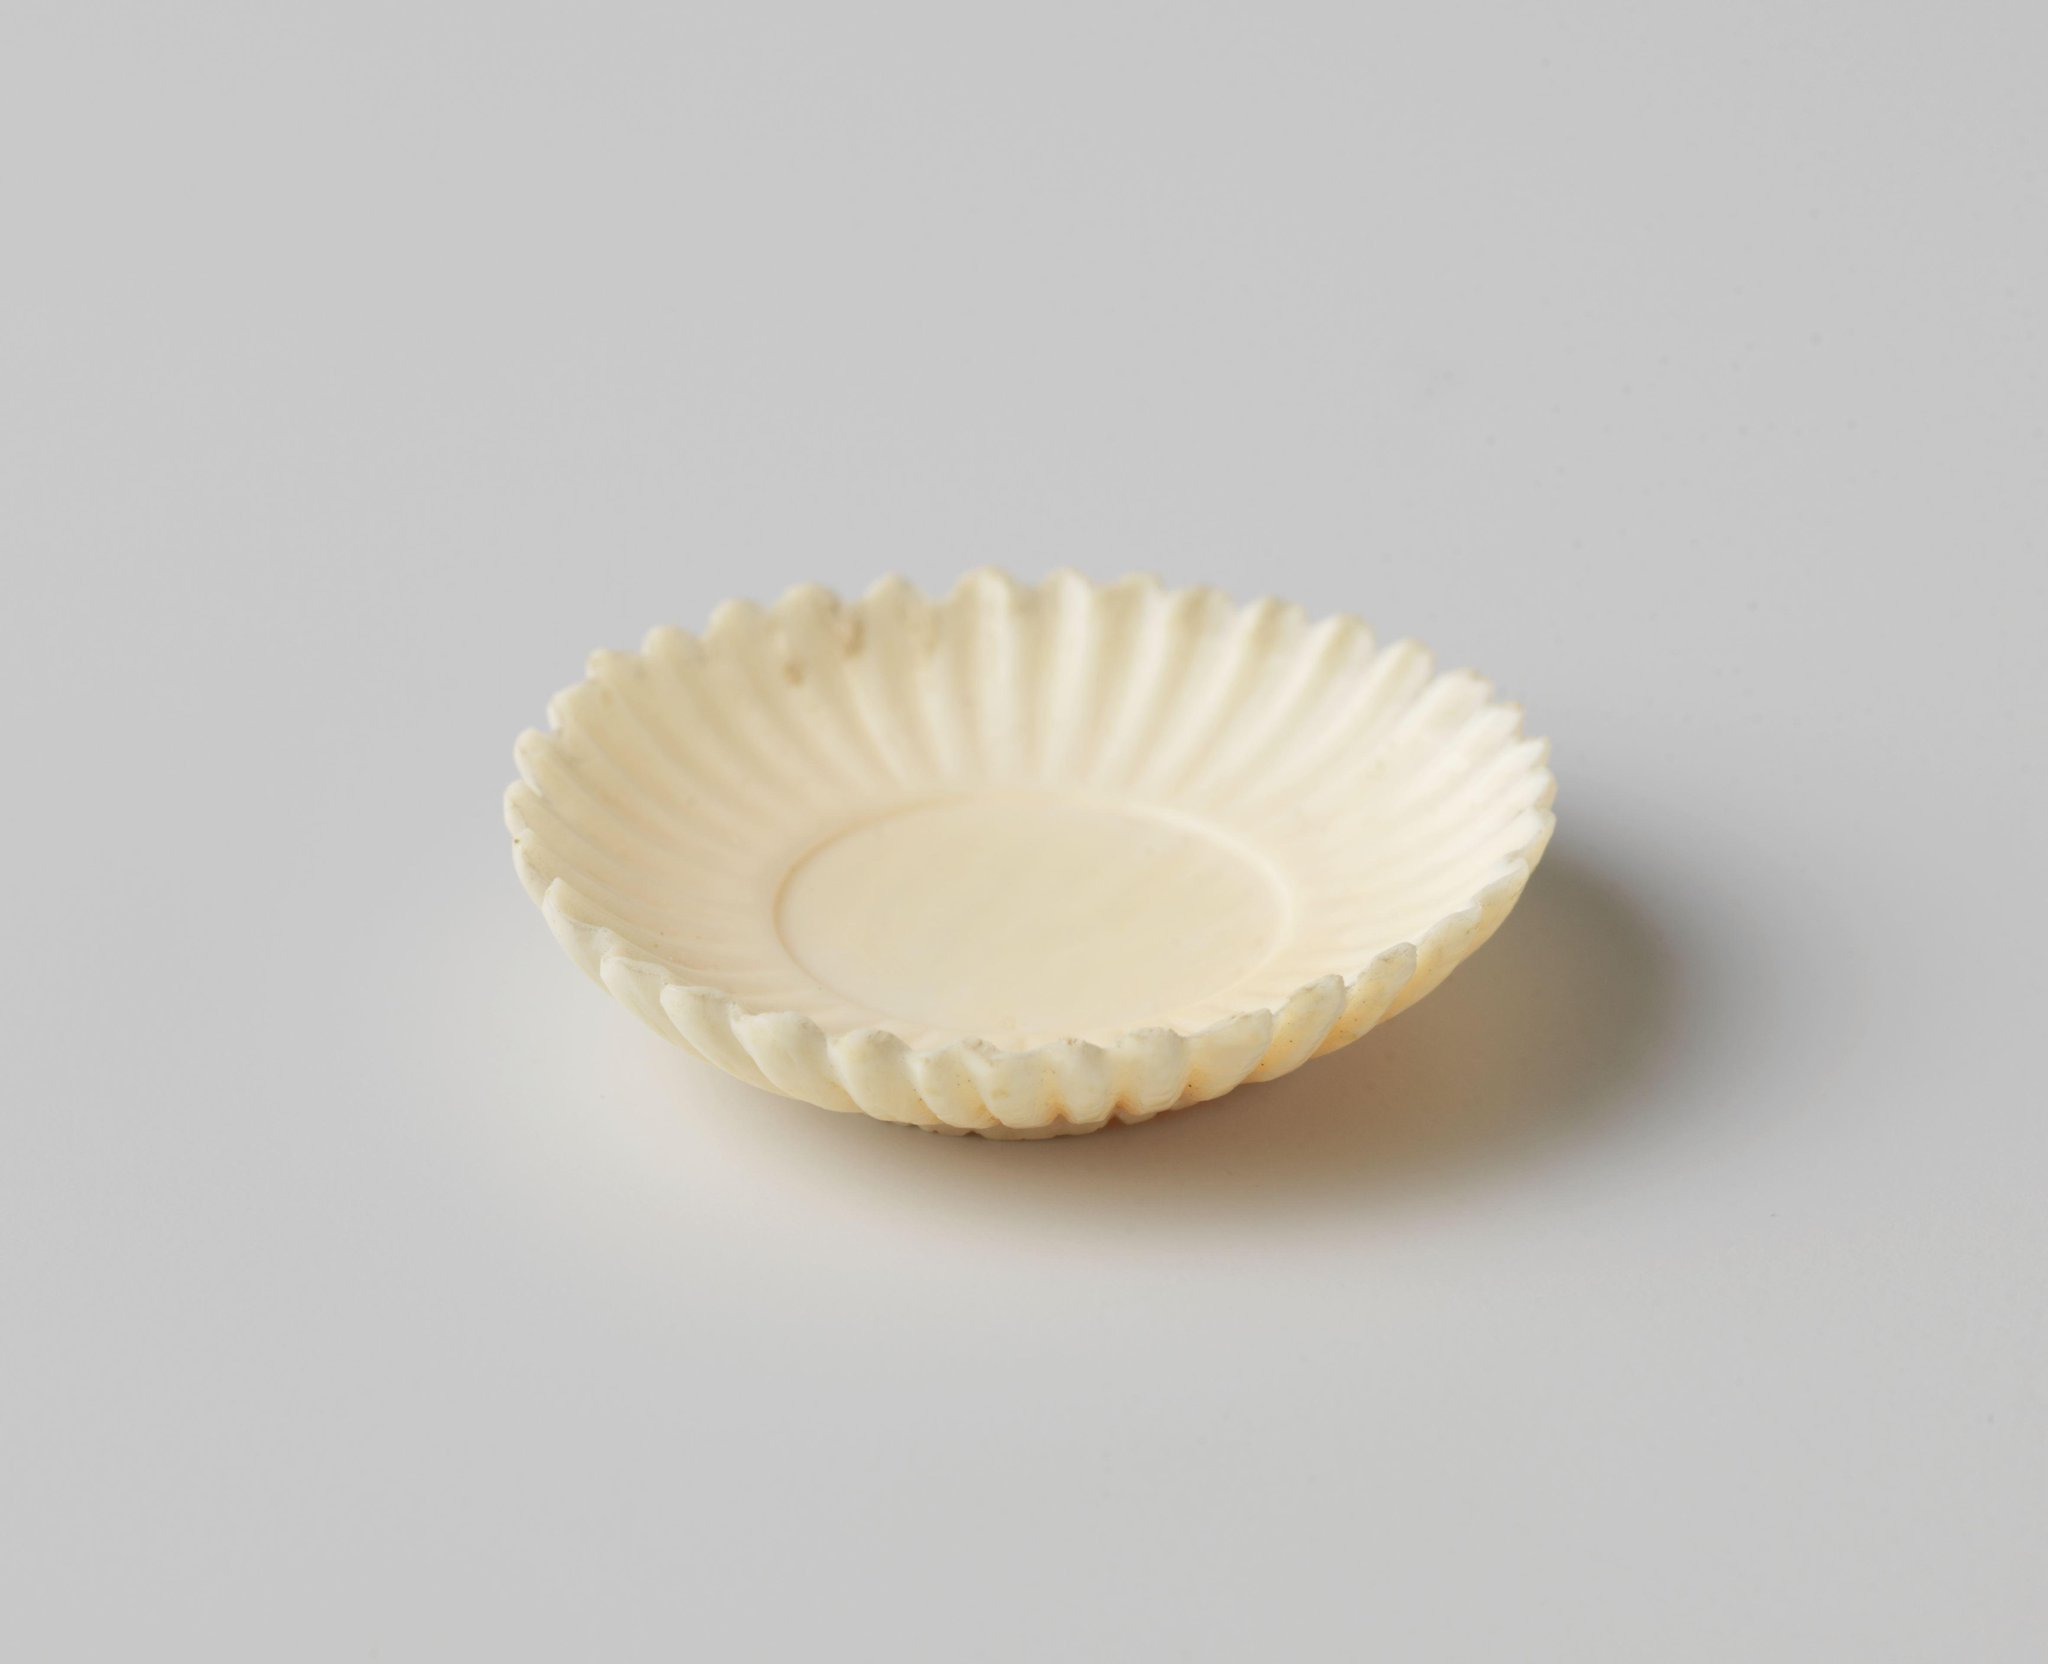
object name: platter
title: Schotel met geschulpte rand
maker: Anonymous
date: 1700-1799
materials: ivory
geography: germany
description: Een schotel van ivoor, met geschulpte rand.